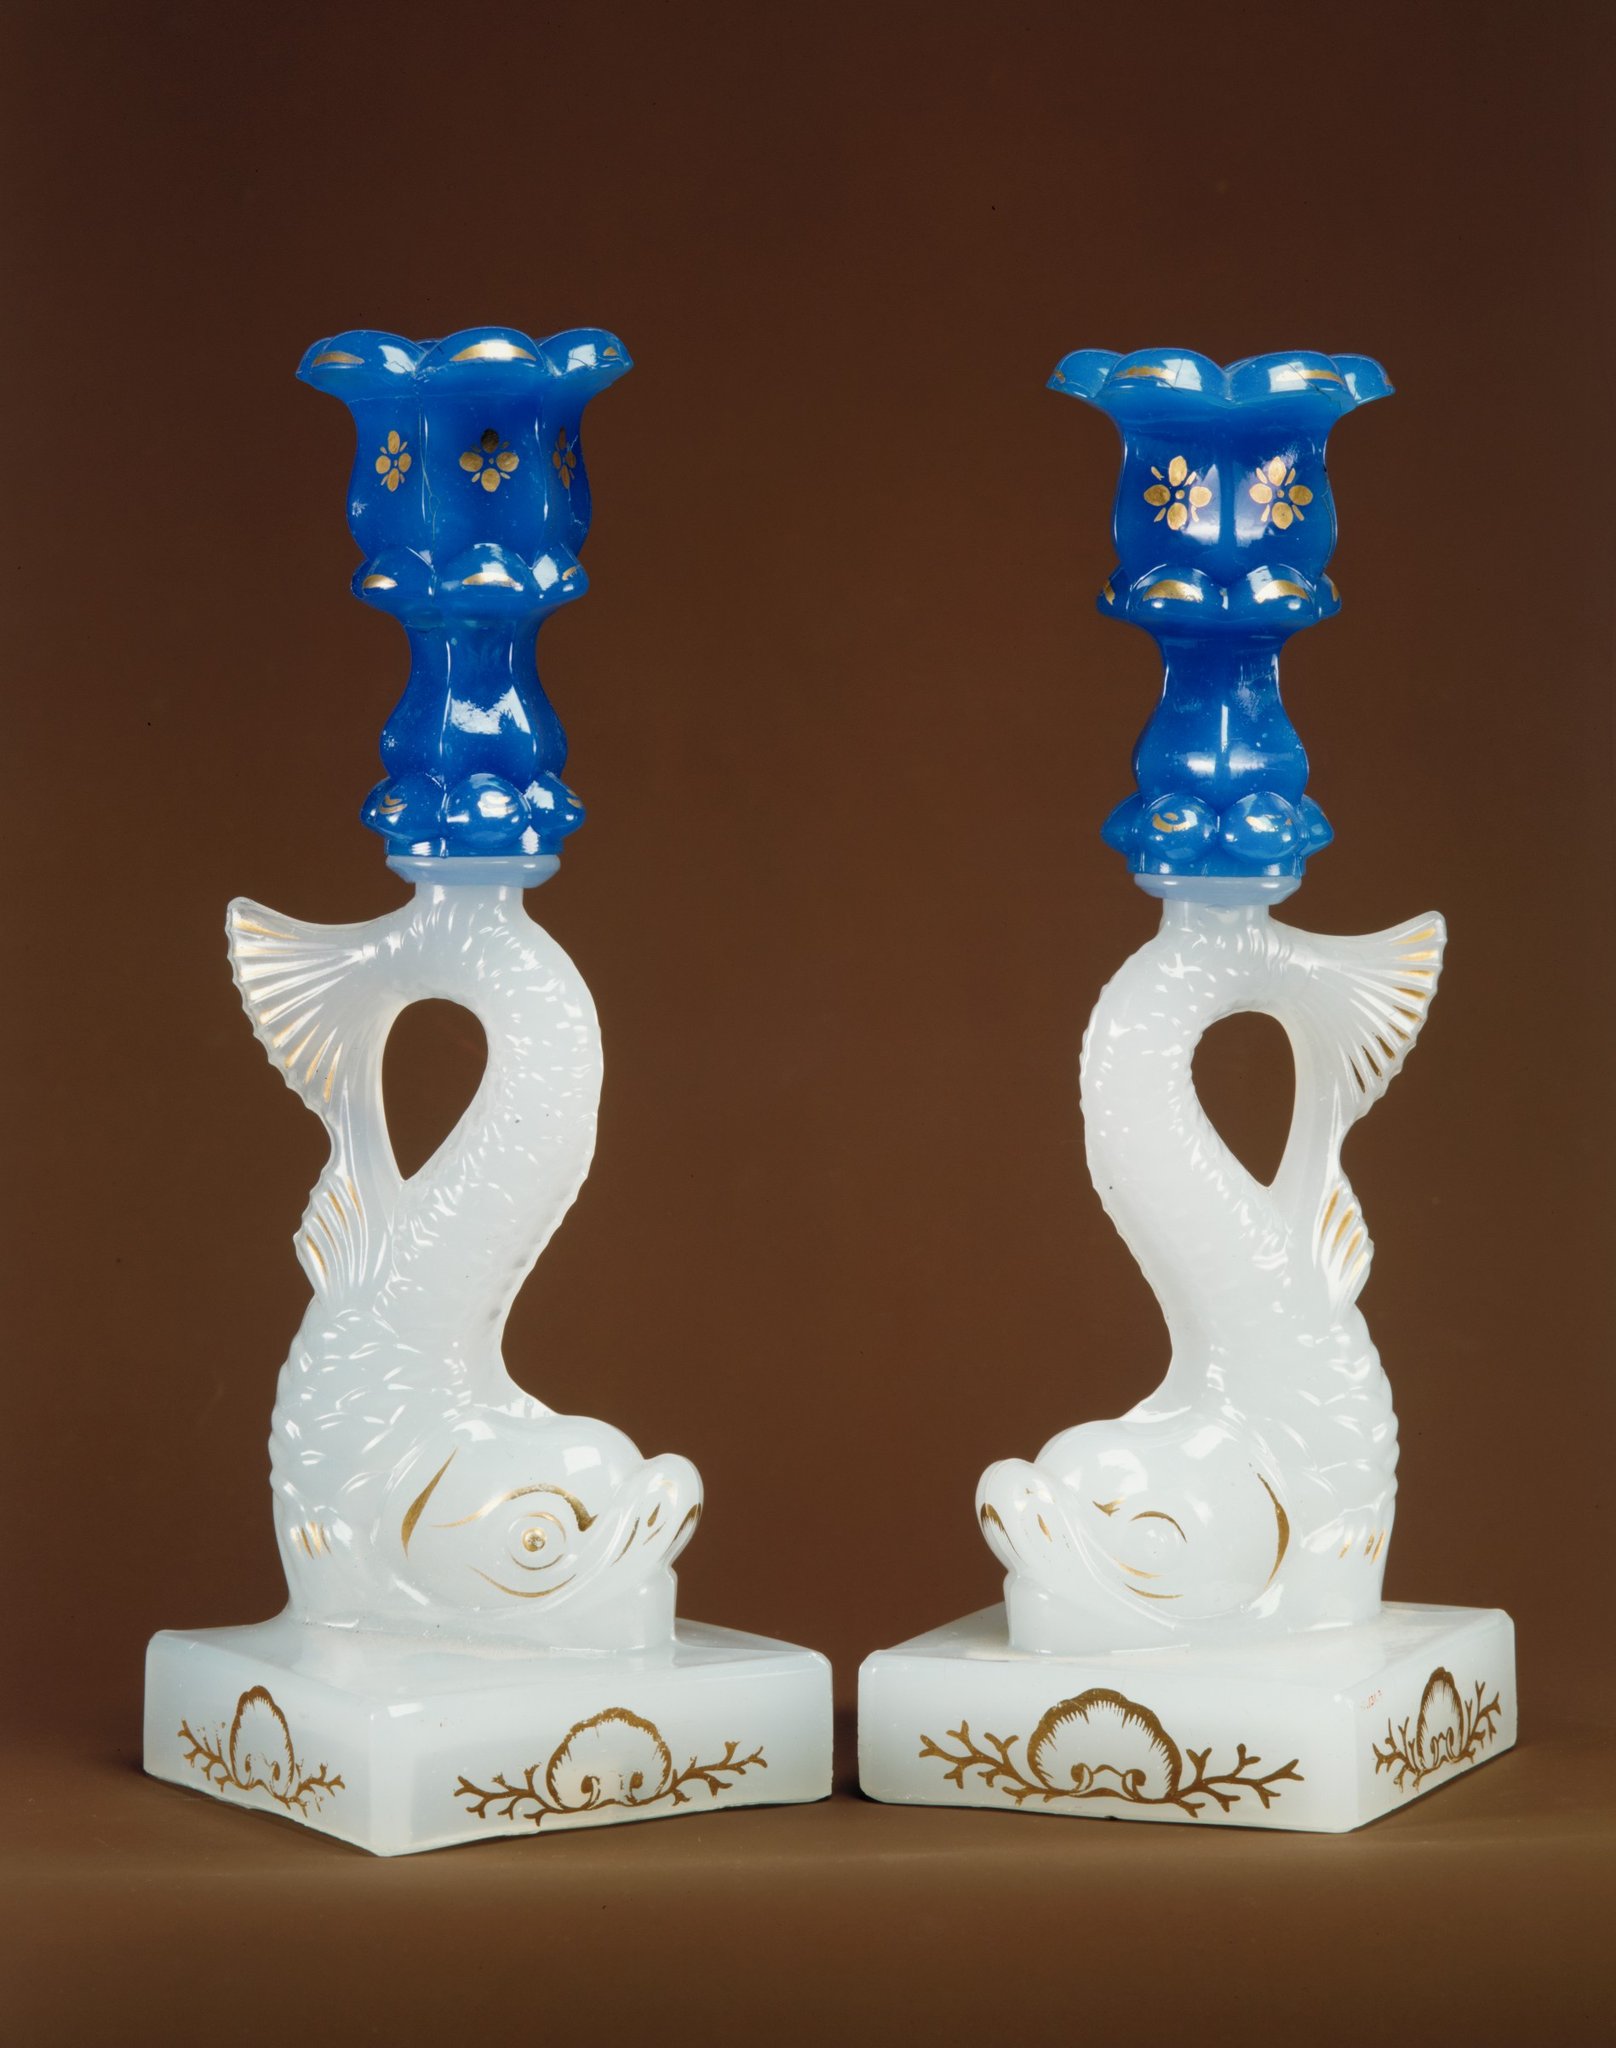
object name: candlestick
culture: american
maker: boston & sandwich glass company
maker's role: maker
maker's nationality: american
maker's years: 1825-1888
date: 1845-1865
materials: glass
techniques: pressed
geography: united states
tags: dolphins